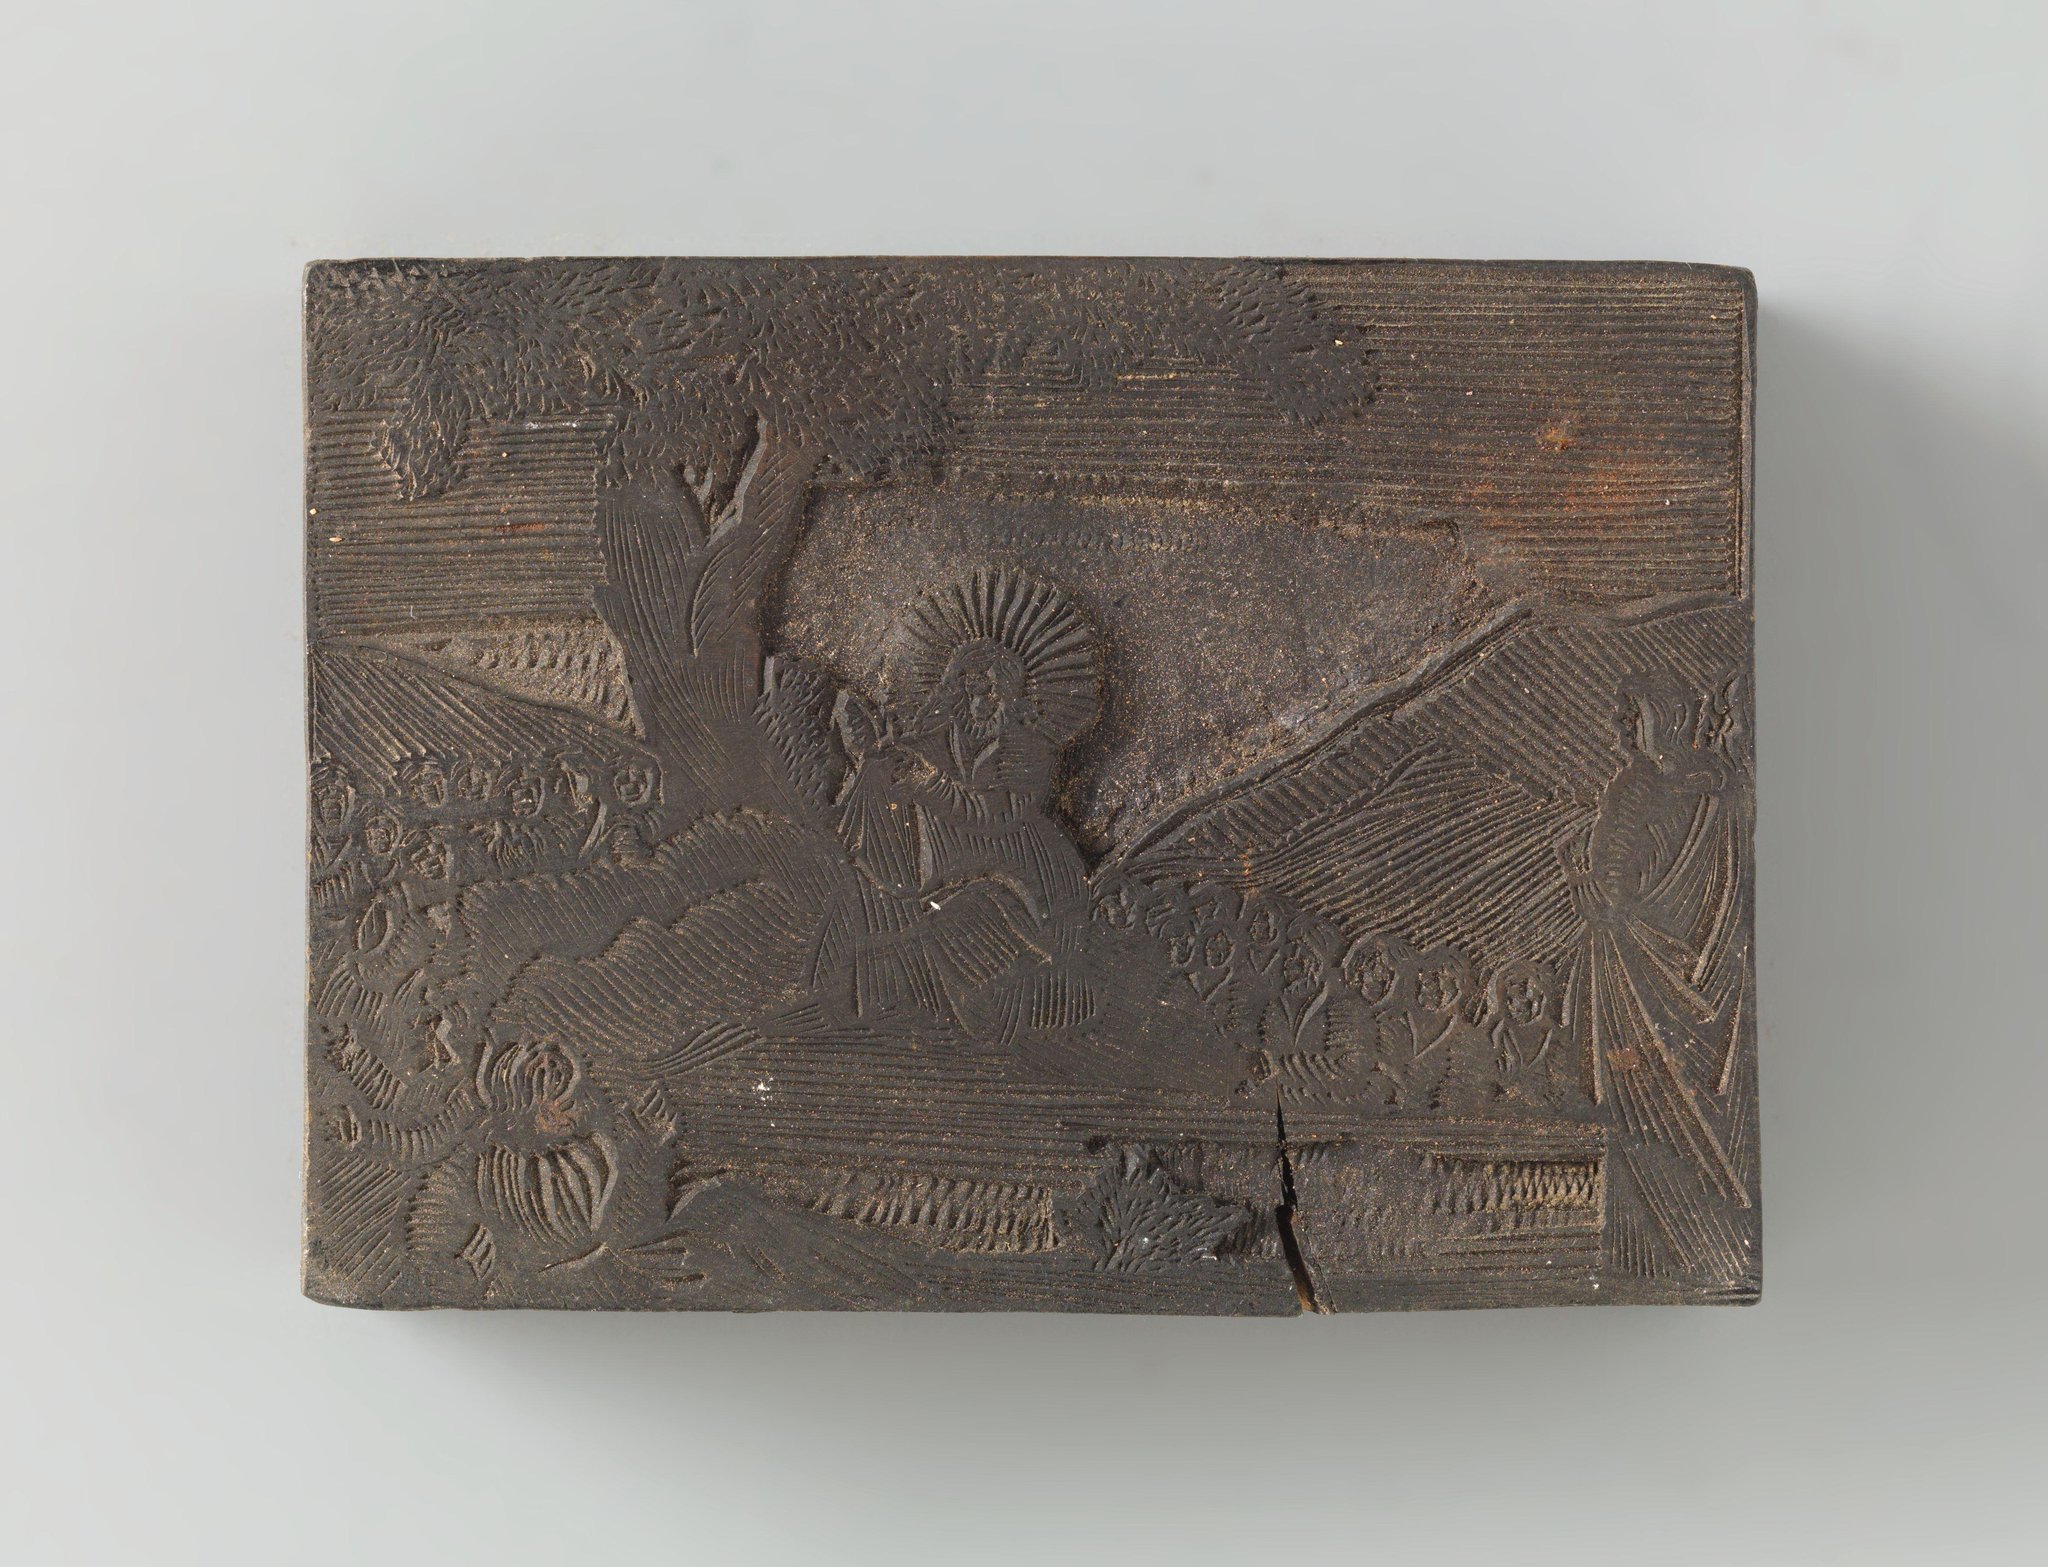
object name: wood block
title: Bijbel-illustraties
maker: Anonymous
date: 1550-1699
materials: wood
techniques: woodcut